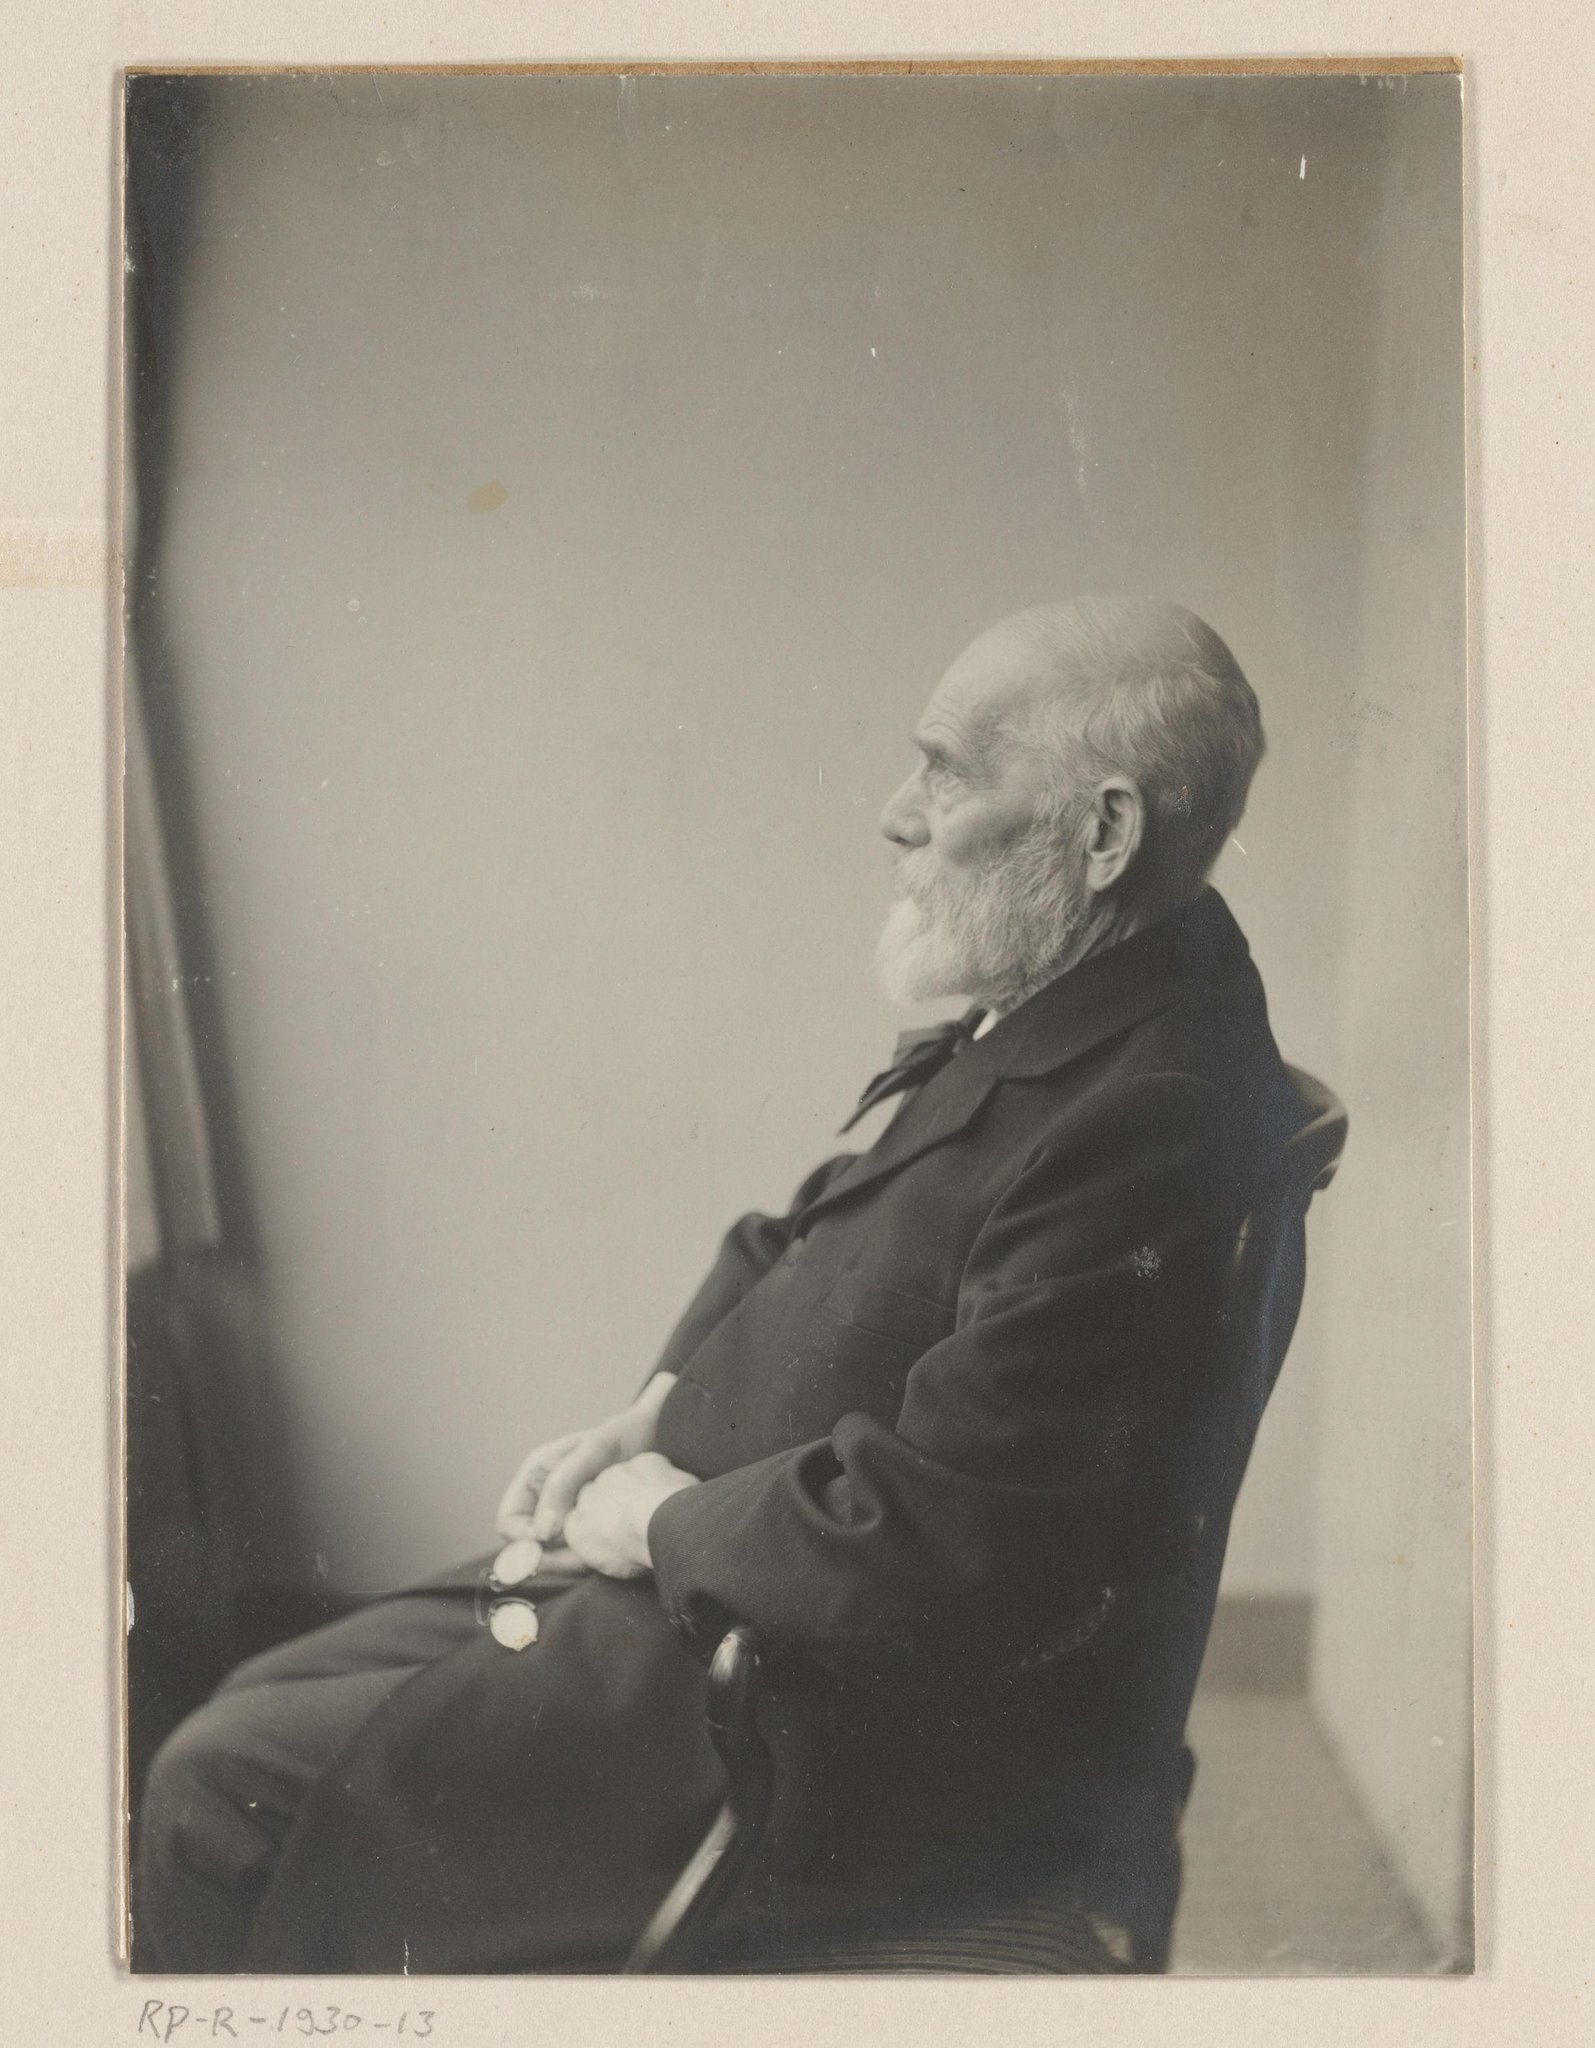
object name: photograph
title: Portret van Johannes Diderik van der Waals, en profil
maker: Anonymous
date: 1920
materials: paper, cardboard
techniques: gelatin silver print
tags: leiden, amsterdam, historical persons